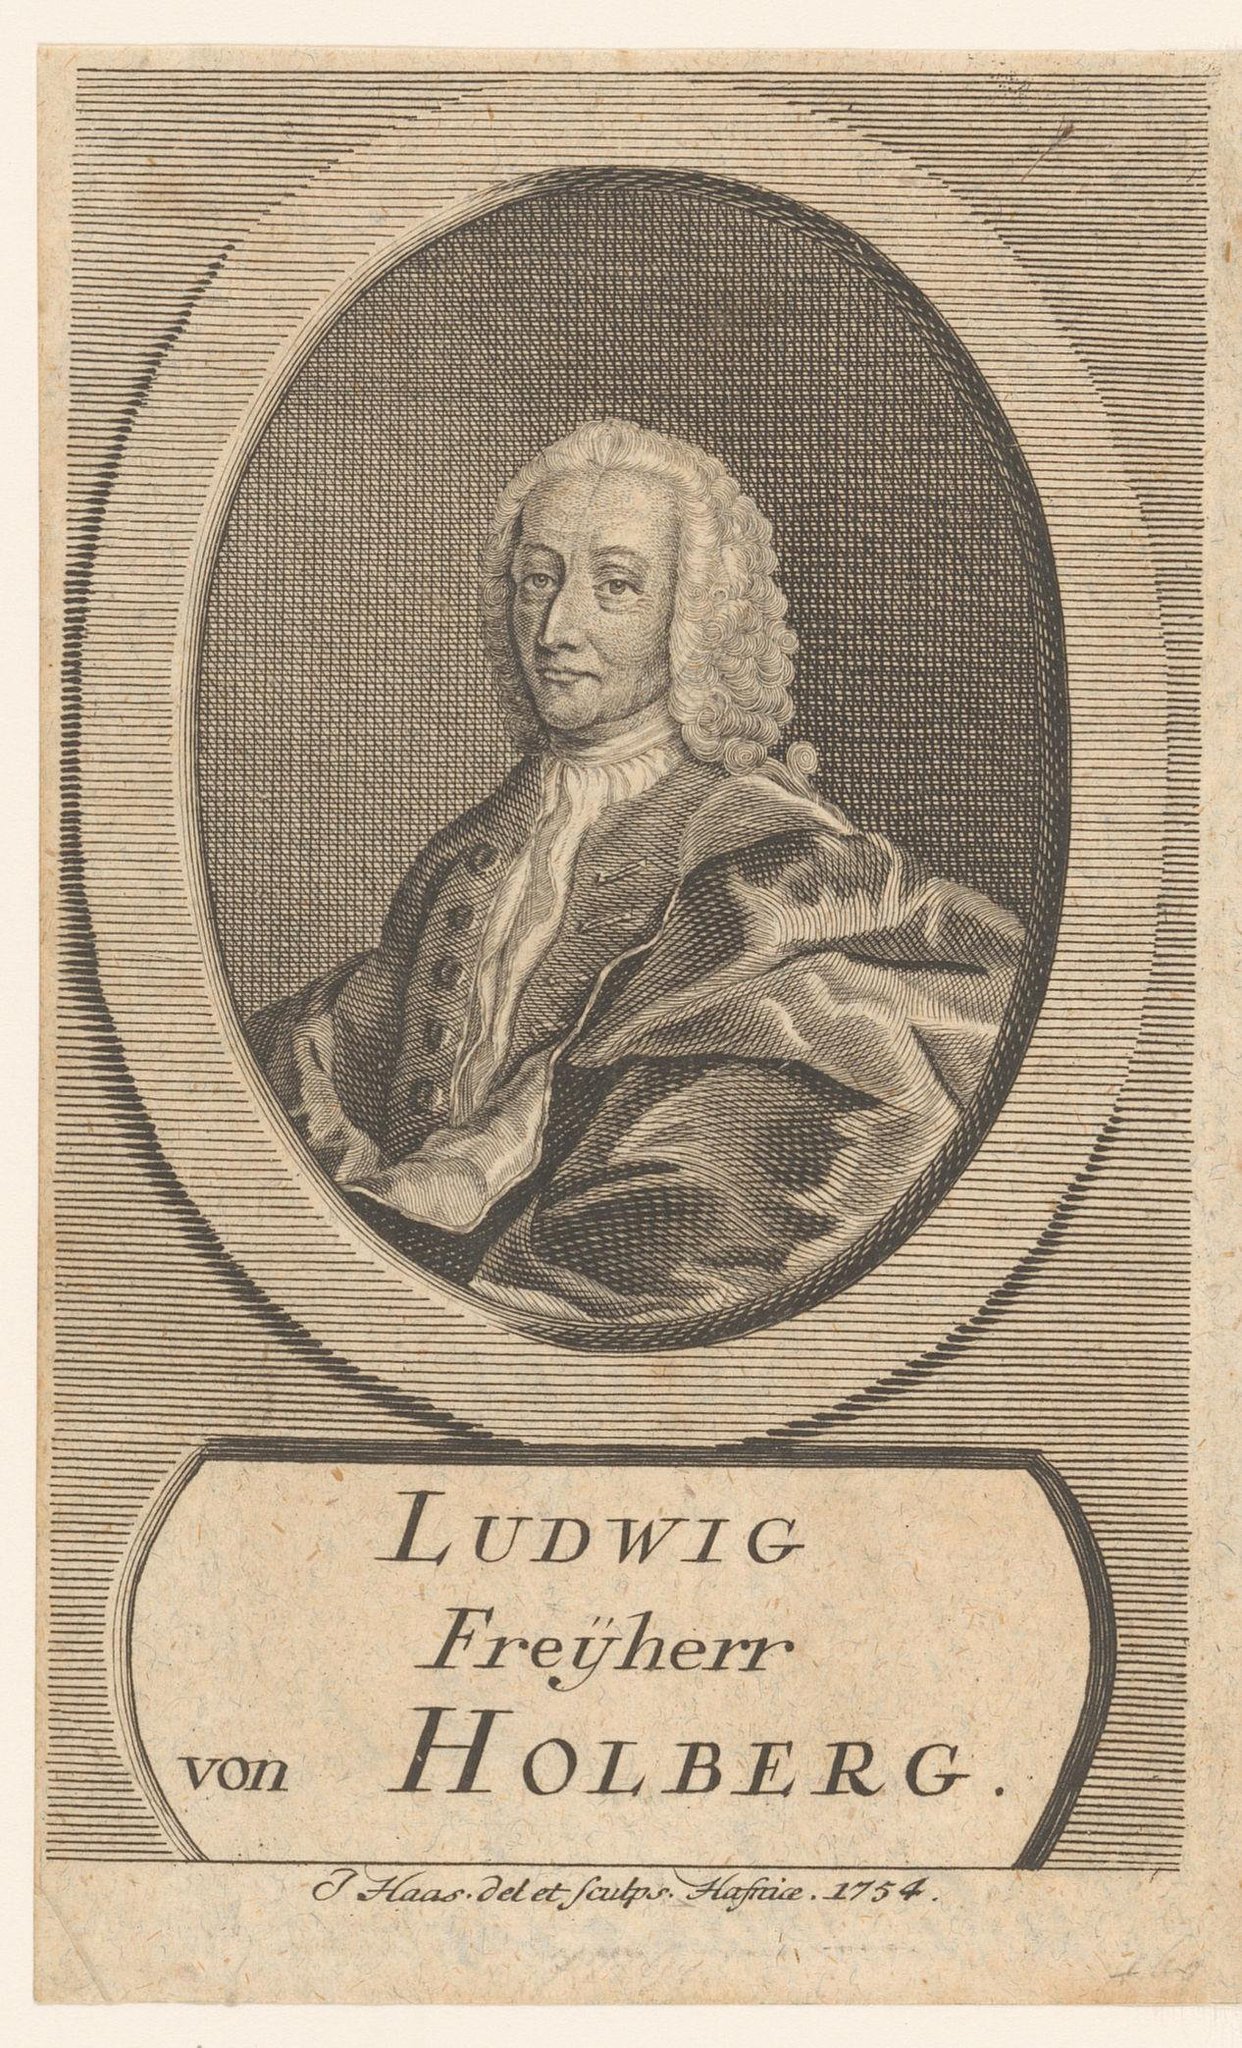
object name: print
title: Portret van Ludvig Holberg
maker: jonas haas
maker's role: print maker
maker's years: 1720-1775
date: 1754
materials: paper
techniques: engraving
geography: copenhagen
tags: historical persons, scholar, philosopher (+ portrait of scholar, scientist)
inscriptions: collector's mark: Lugt 2228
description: Portret van de Deens-Noorse schrijver Ludvig Holberg, ten halven lijve in ovaal, naar links.